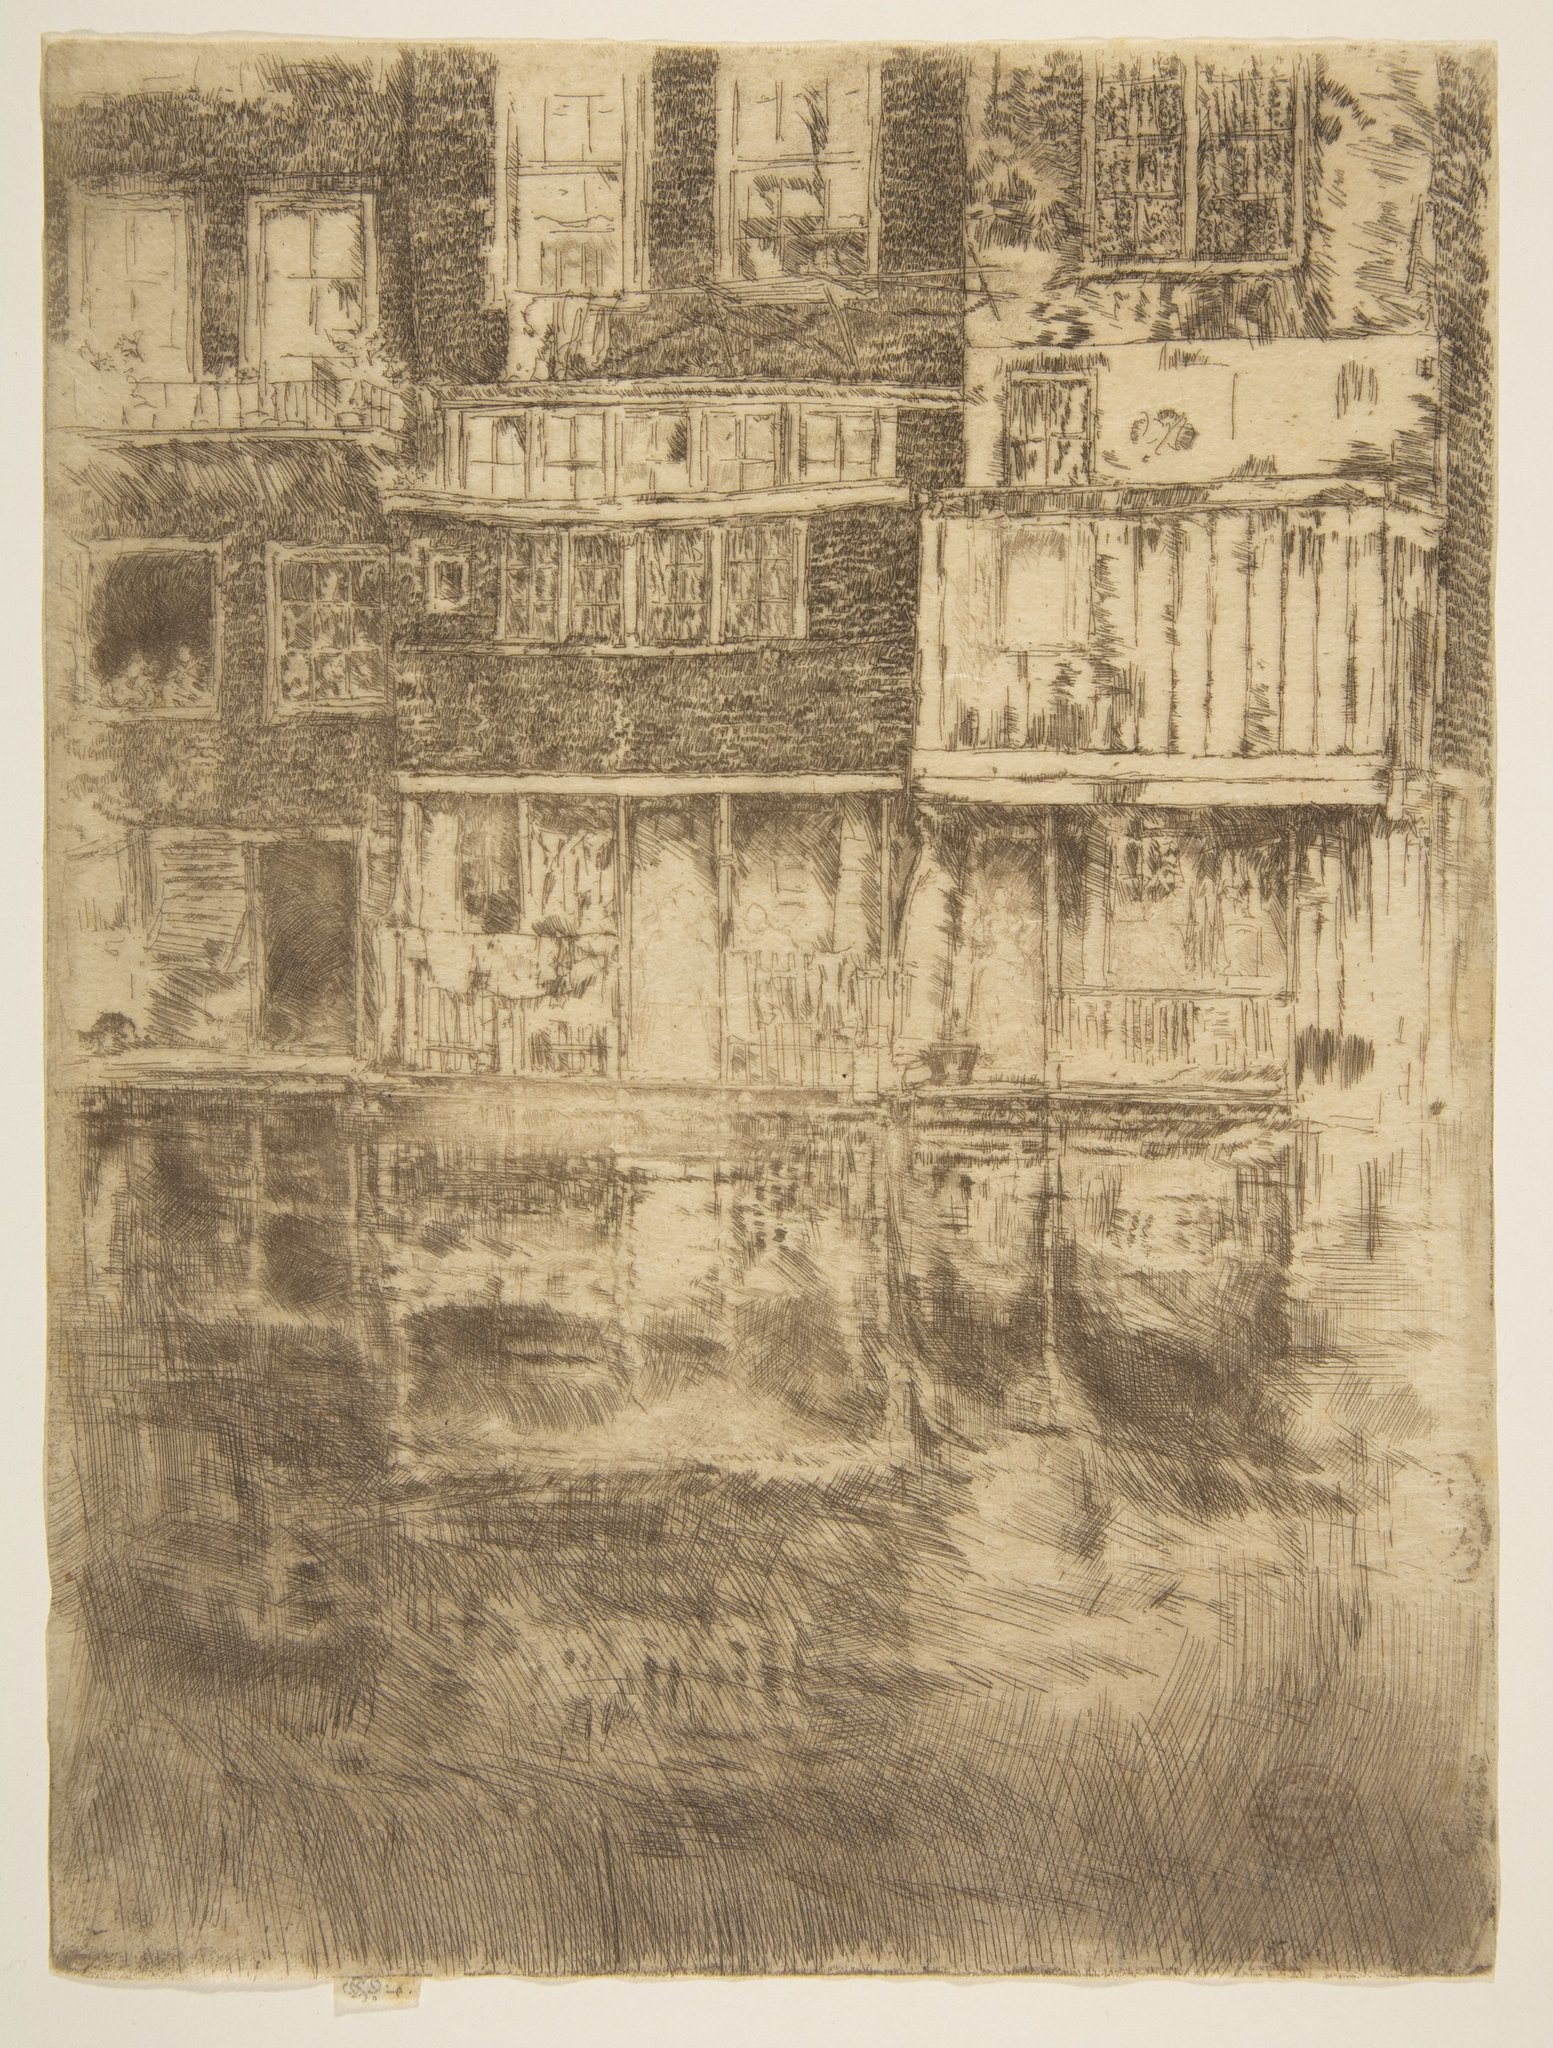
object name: print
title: Square House, Amsterdam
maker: james mcneill whistler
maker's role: artist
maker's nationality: american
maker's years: 1834-1903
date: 1889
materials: ink, ivory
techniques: drypoint, etching, printing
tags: houses,amsterdam